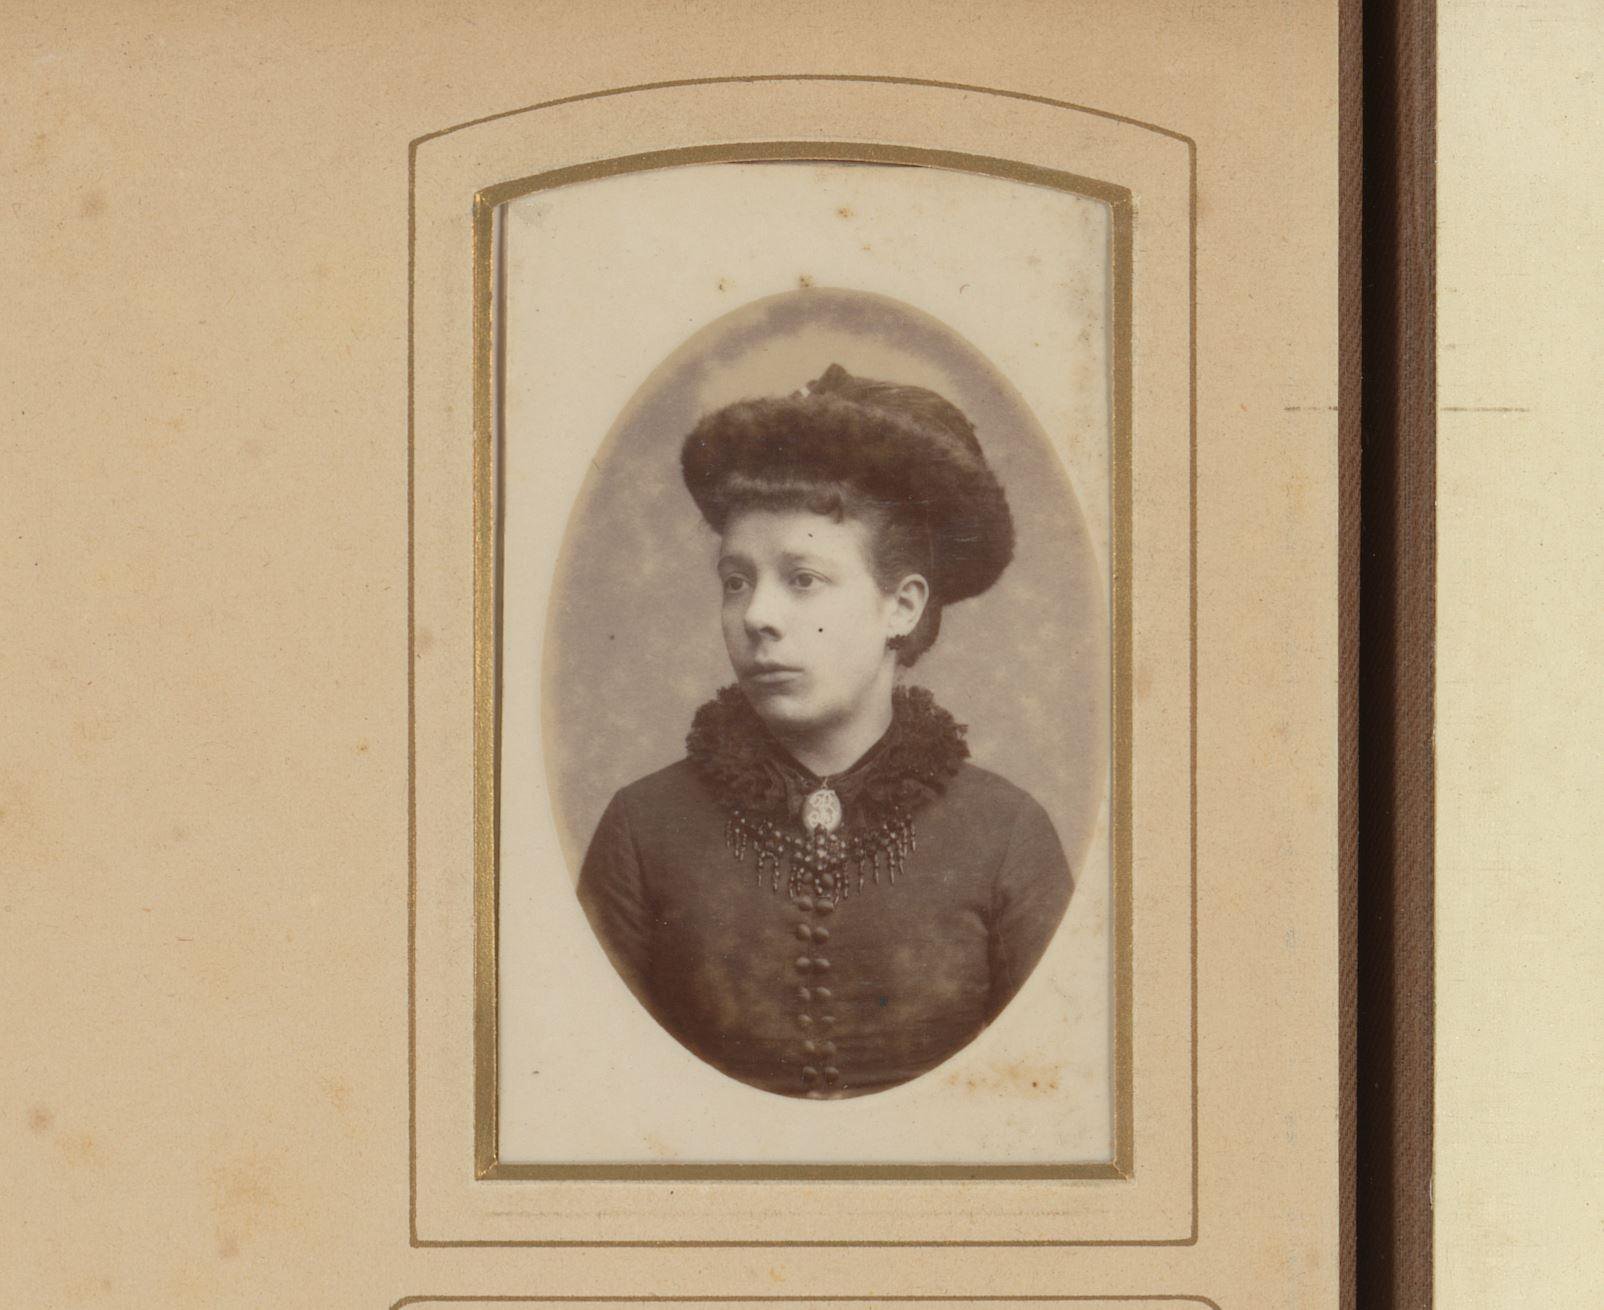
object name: carte de visite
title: Portret van een jonge vrouw met halssieraad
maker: j. van crewel jeune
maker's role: fotograaf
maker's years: 1852-1930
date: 1883-1905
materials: cardboard, celluloid, photographic support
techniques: albumen print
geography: antwerp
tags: adolescent, young woman, maiden, historical persons - bb - woman, necklace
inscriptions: inscription: ‘BREVET D'INVENTION/ MÉDAILLE D'ARGENT A/ L'EXPOSITION RUBENS 1881/ obtenue/ pour le procédé instantané./ MAISON/ J. VAN CREWEL JEUNE/ Photographe (Bréveté)/ 44 rue du Pélican, 44/ EN FACE DE LA GARE/ ANvers./ Tous les Clichés sont conservés.’